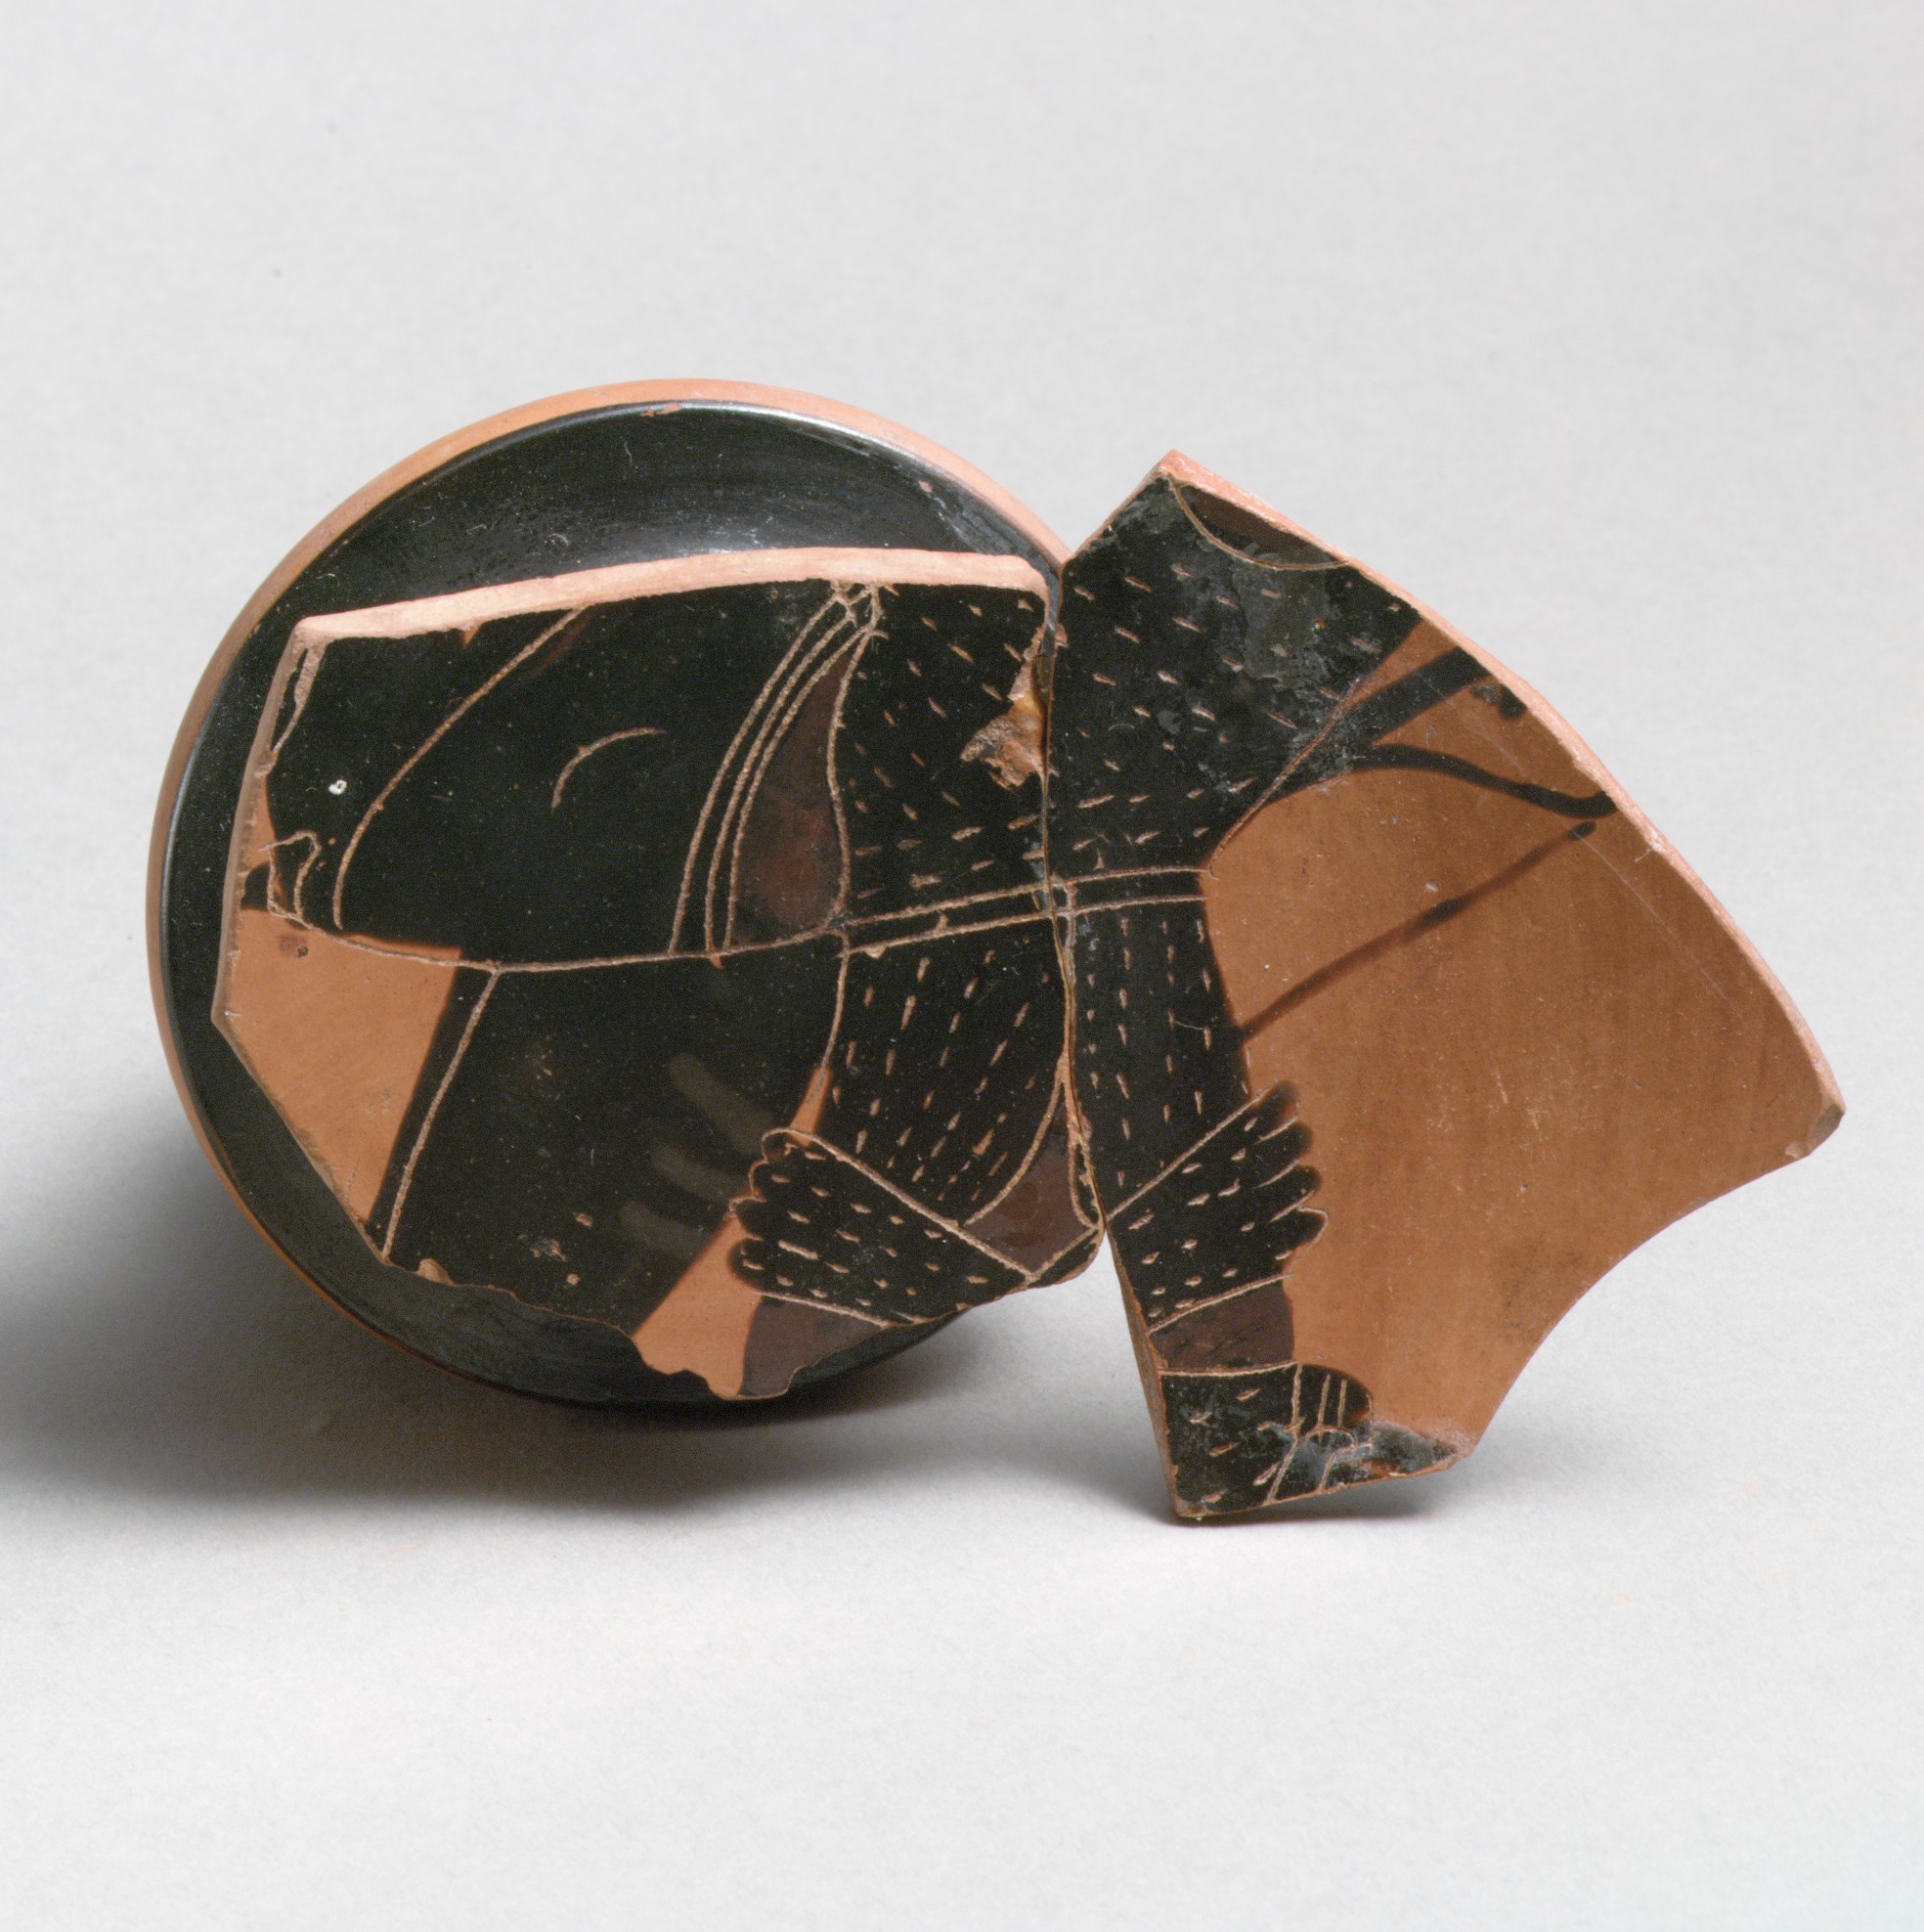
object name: kylix fragment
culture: greek, attic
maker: segment class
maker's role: artist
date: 510 BCE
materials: terracotta